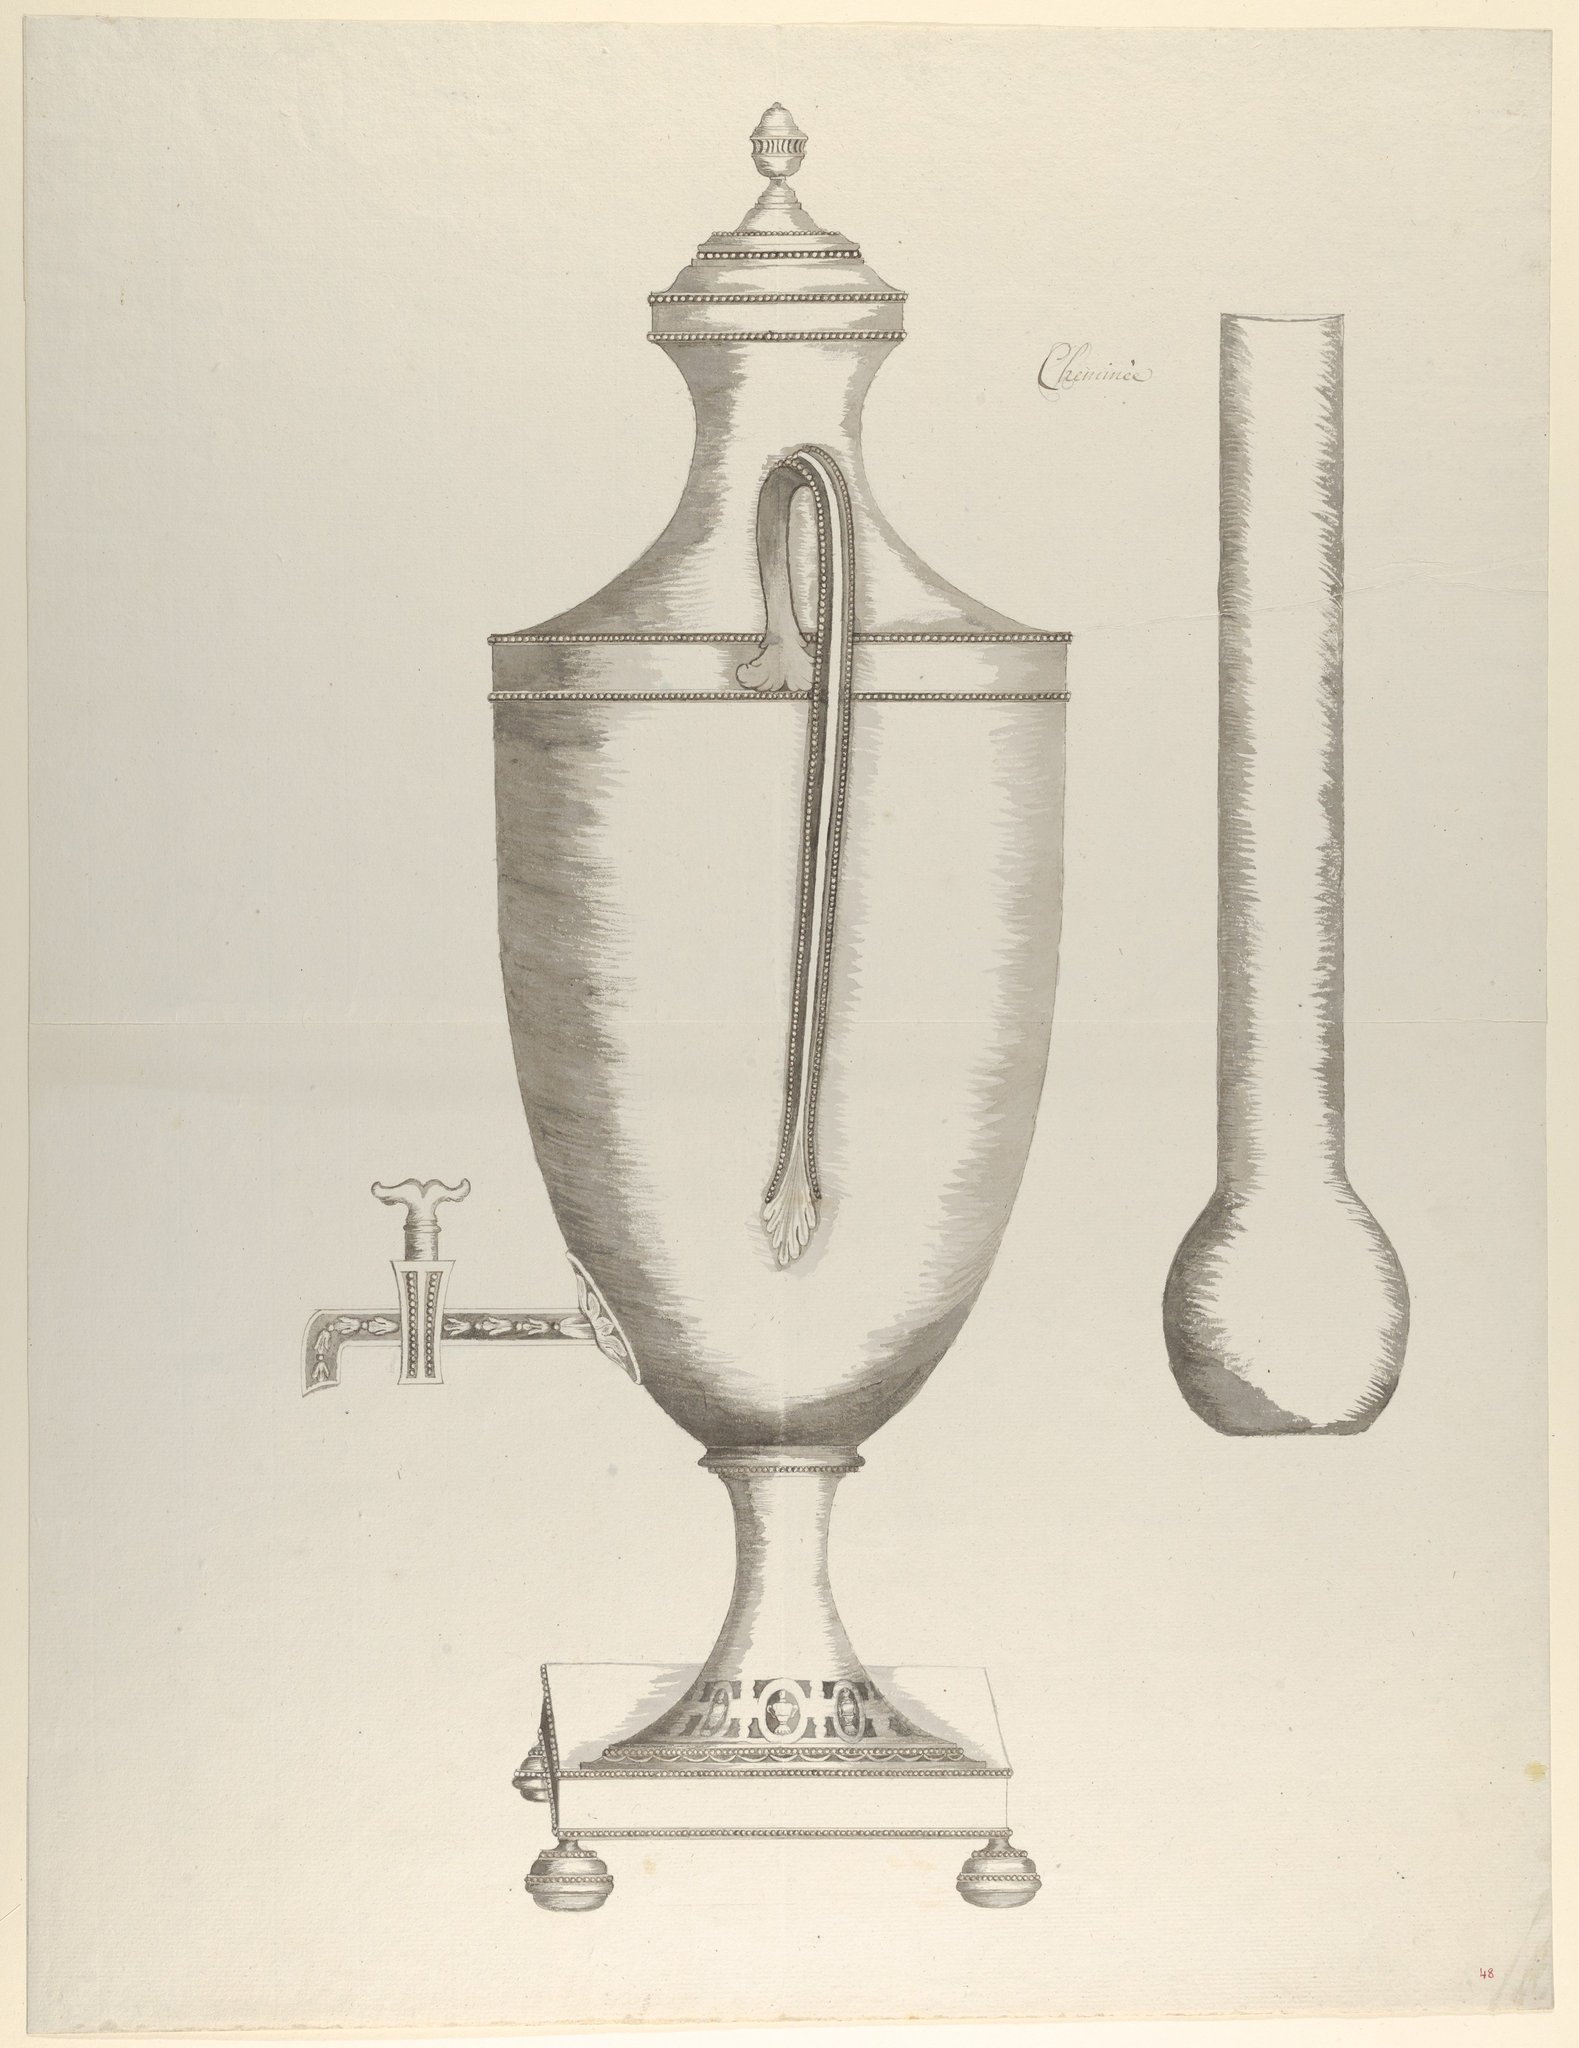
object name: drawing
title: Design for a Coffee Urn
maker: anonymous, french, 18th century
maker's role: artist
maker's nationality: french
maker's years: 1700-1800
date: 1770-1790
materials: graphite, ink, paper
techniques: brush, pen, drawing, wash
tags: urns